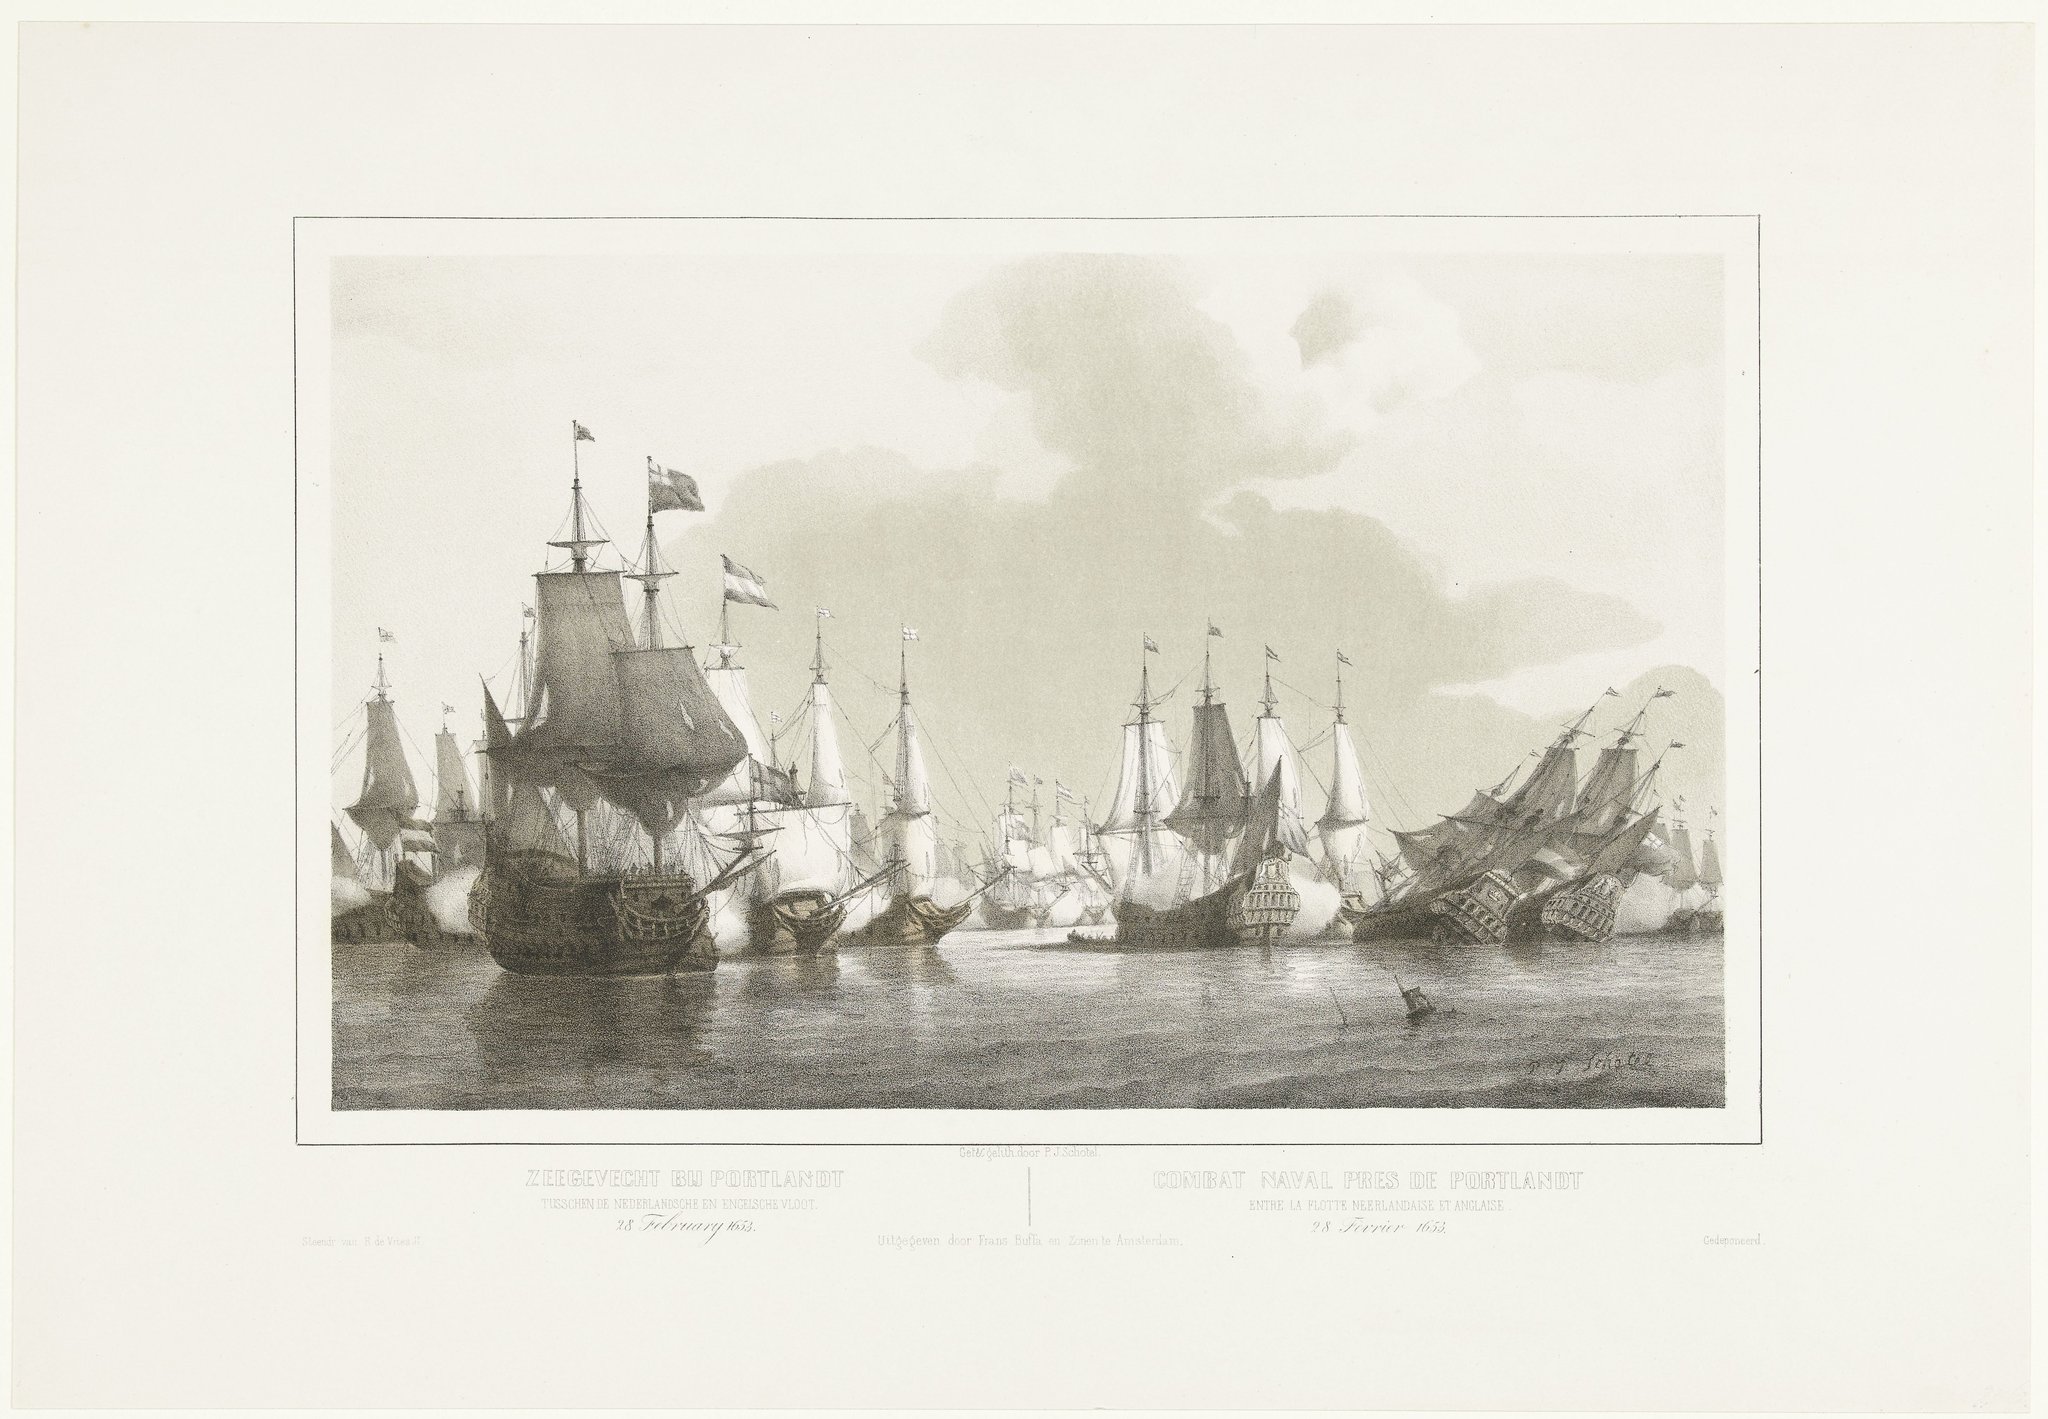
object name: print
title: Zeegevecht bij Portlandt tusschen de Nederlandsche en Engelsche vloot. 28 February 1653 / Combat naval pres de Portlandt entre la flotte Neerlandaise et Anglaise. 28 Février 1653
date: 1848-1855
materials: paper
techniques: lithograph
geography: amsterdam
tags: brielle, maarten harpertszoon tromp, battle (+ naval force), battle of portland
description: Uitgegeven in: P.J. Schotel, Heldendaden der Nederlanders ter zee, van de vroegste tijden tot op heden, naar aanleiding van de: Geschiedenis van het Nederlandsche zeewezen, Frans Buffa en Zonen, Amsterdam 1850-1855, pl. 17. Zonder de uitvoerige beschrijving vermeld bij Muller.